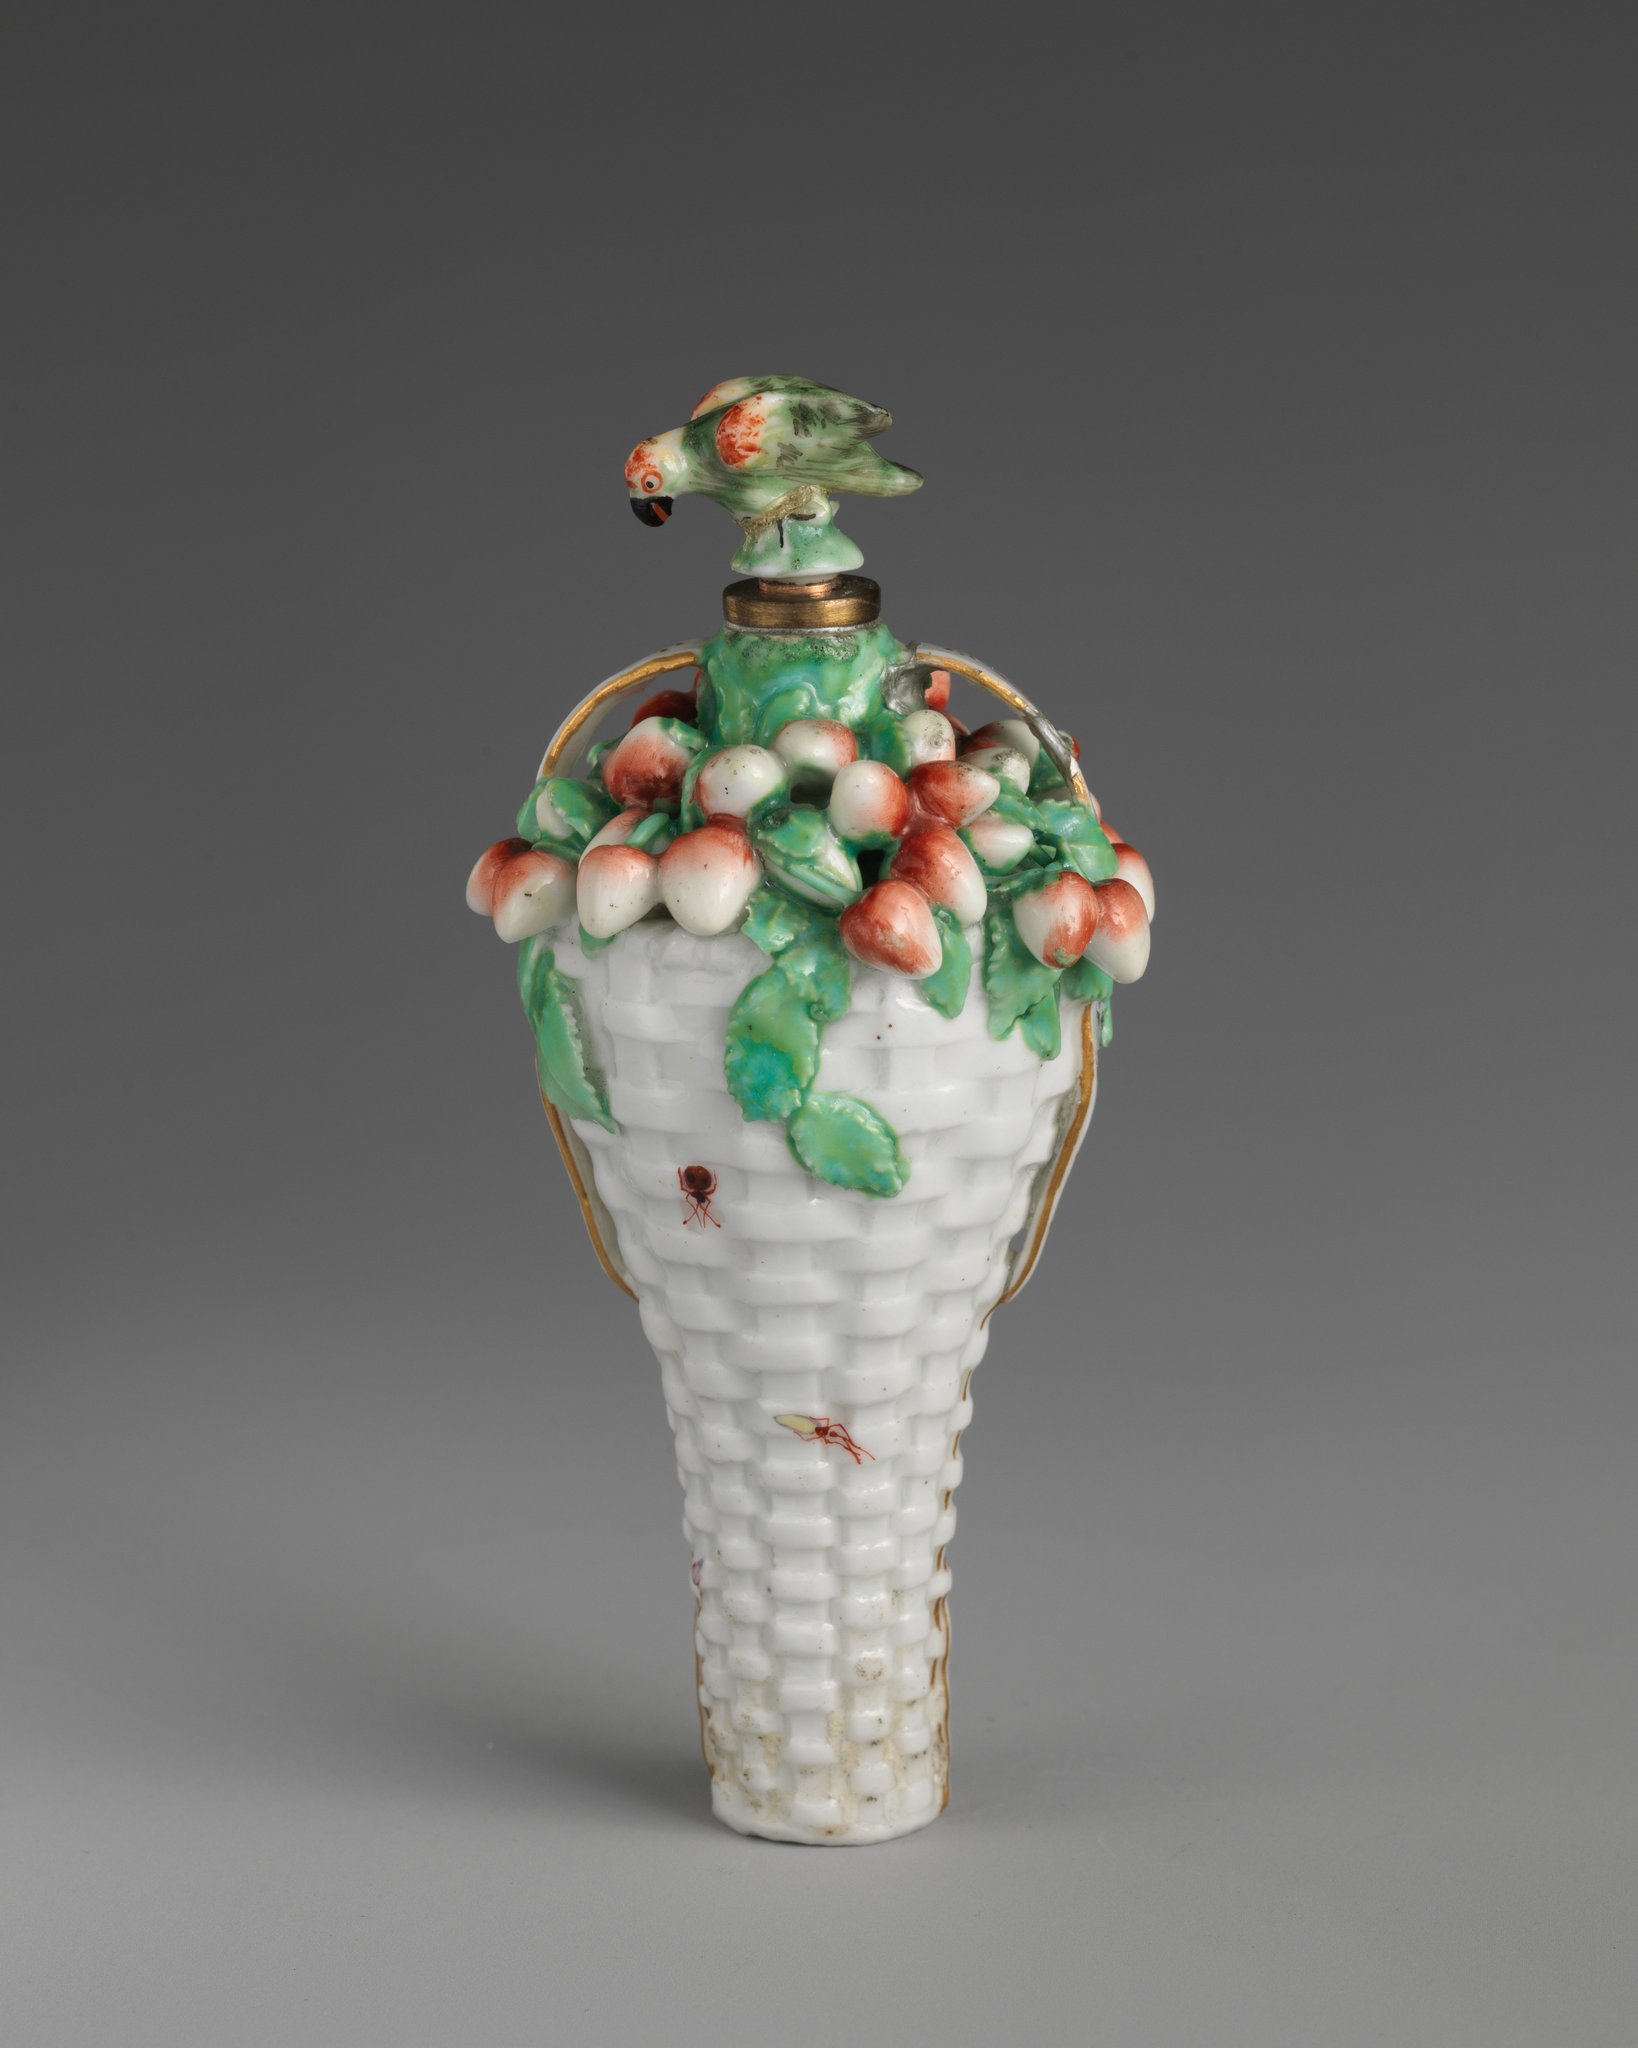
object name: toy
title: Basket of cherries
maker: chelsea porcelain manufactory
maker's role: factory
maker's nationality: british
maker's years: 1744-1784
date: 1755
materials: soft paste porcelain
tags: birds,cherries,leaves